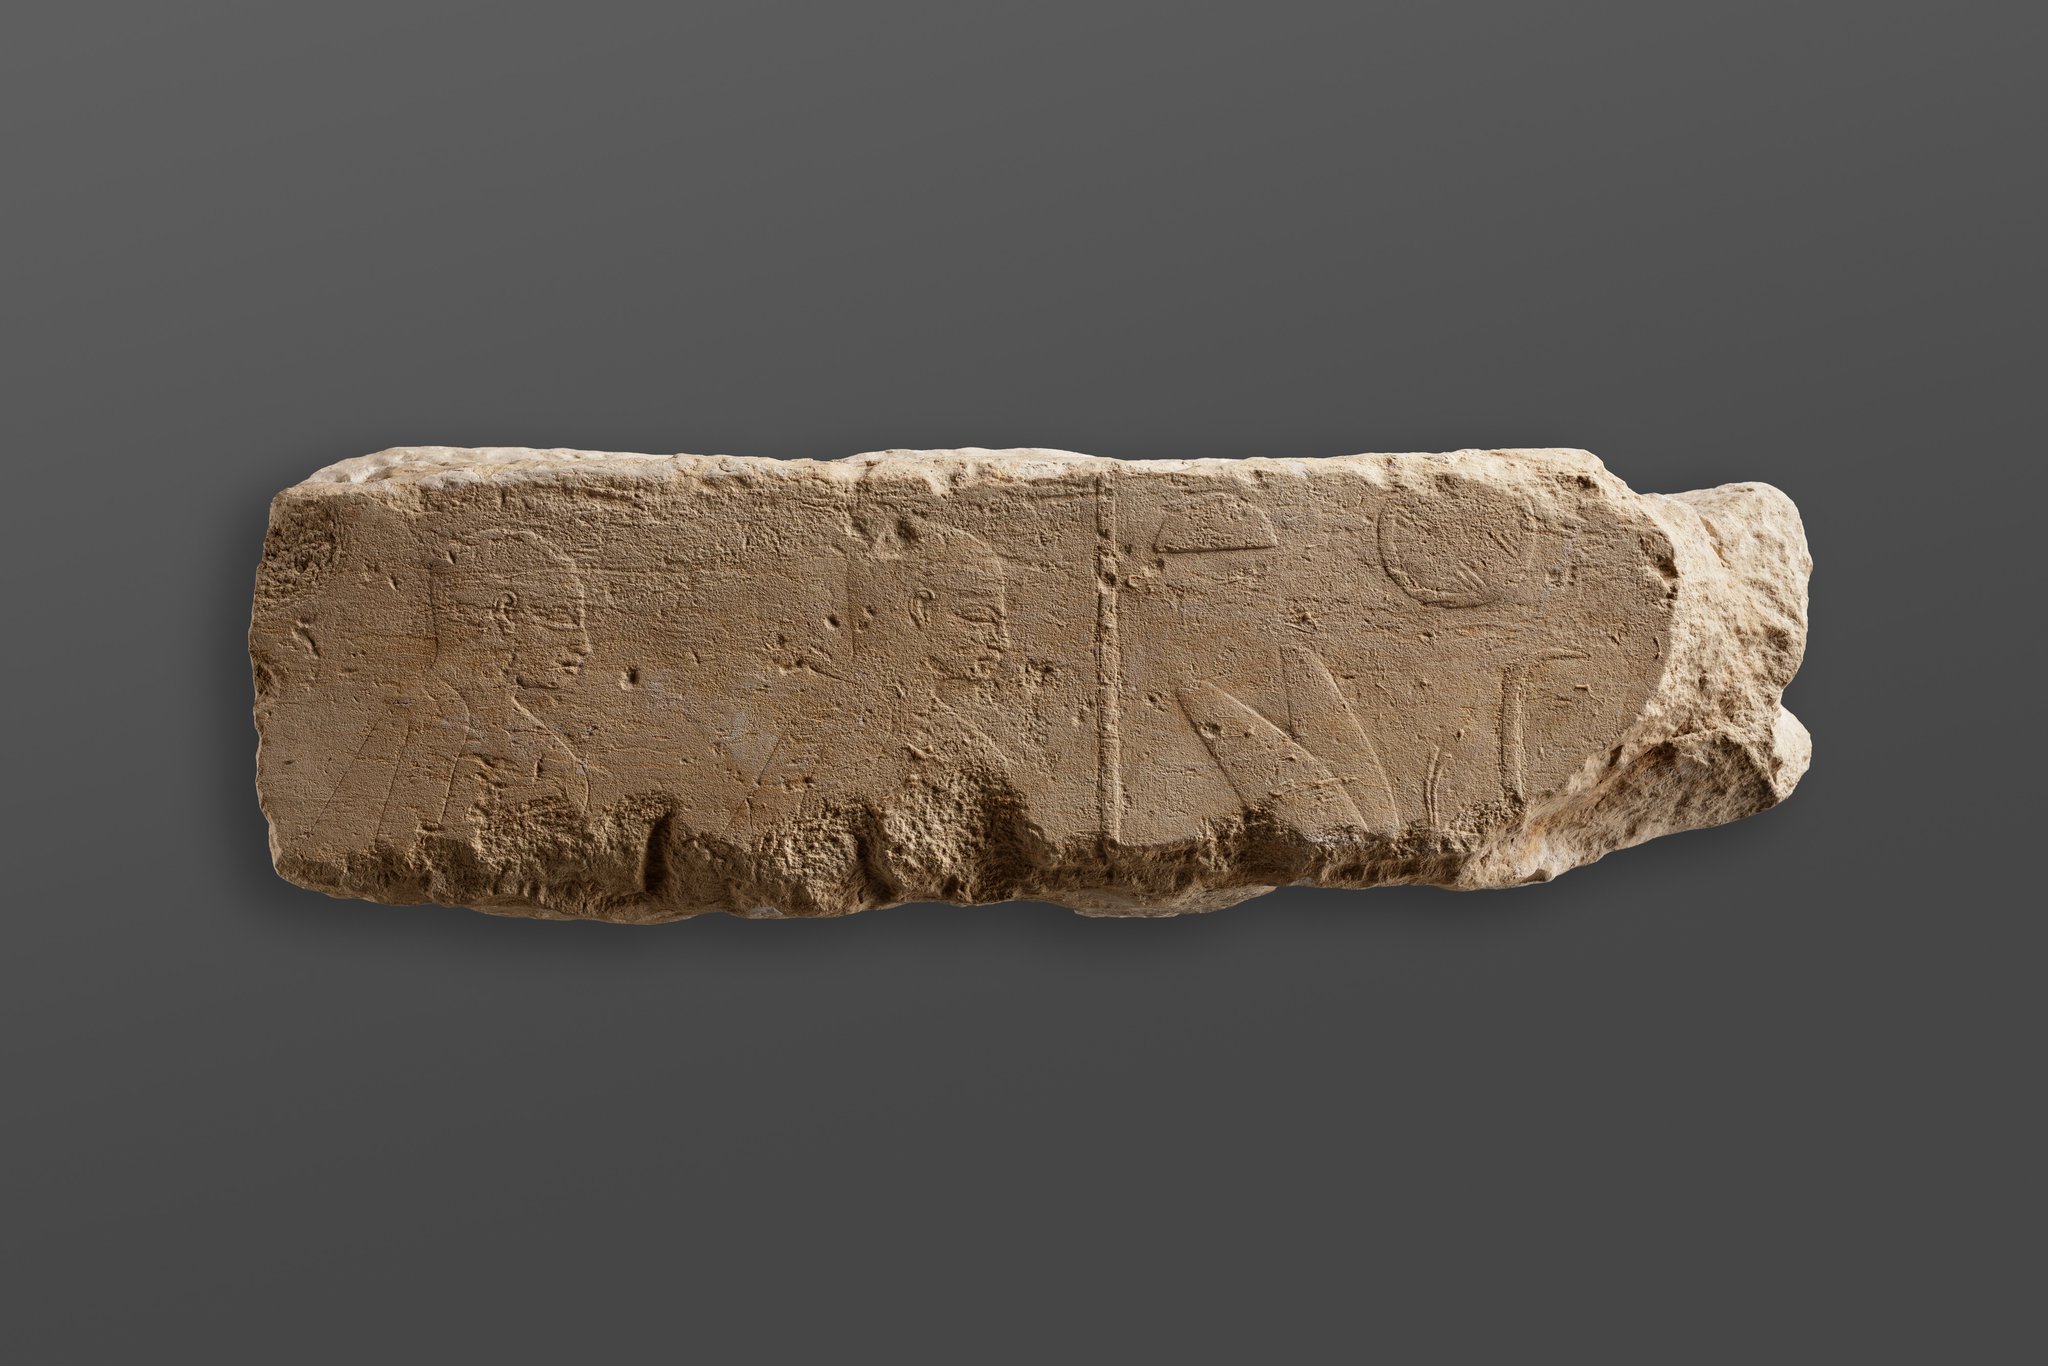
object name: relief fragment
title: Fragment of relief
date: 1961-1917 BCE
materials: limestone, paint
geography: egypt